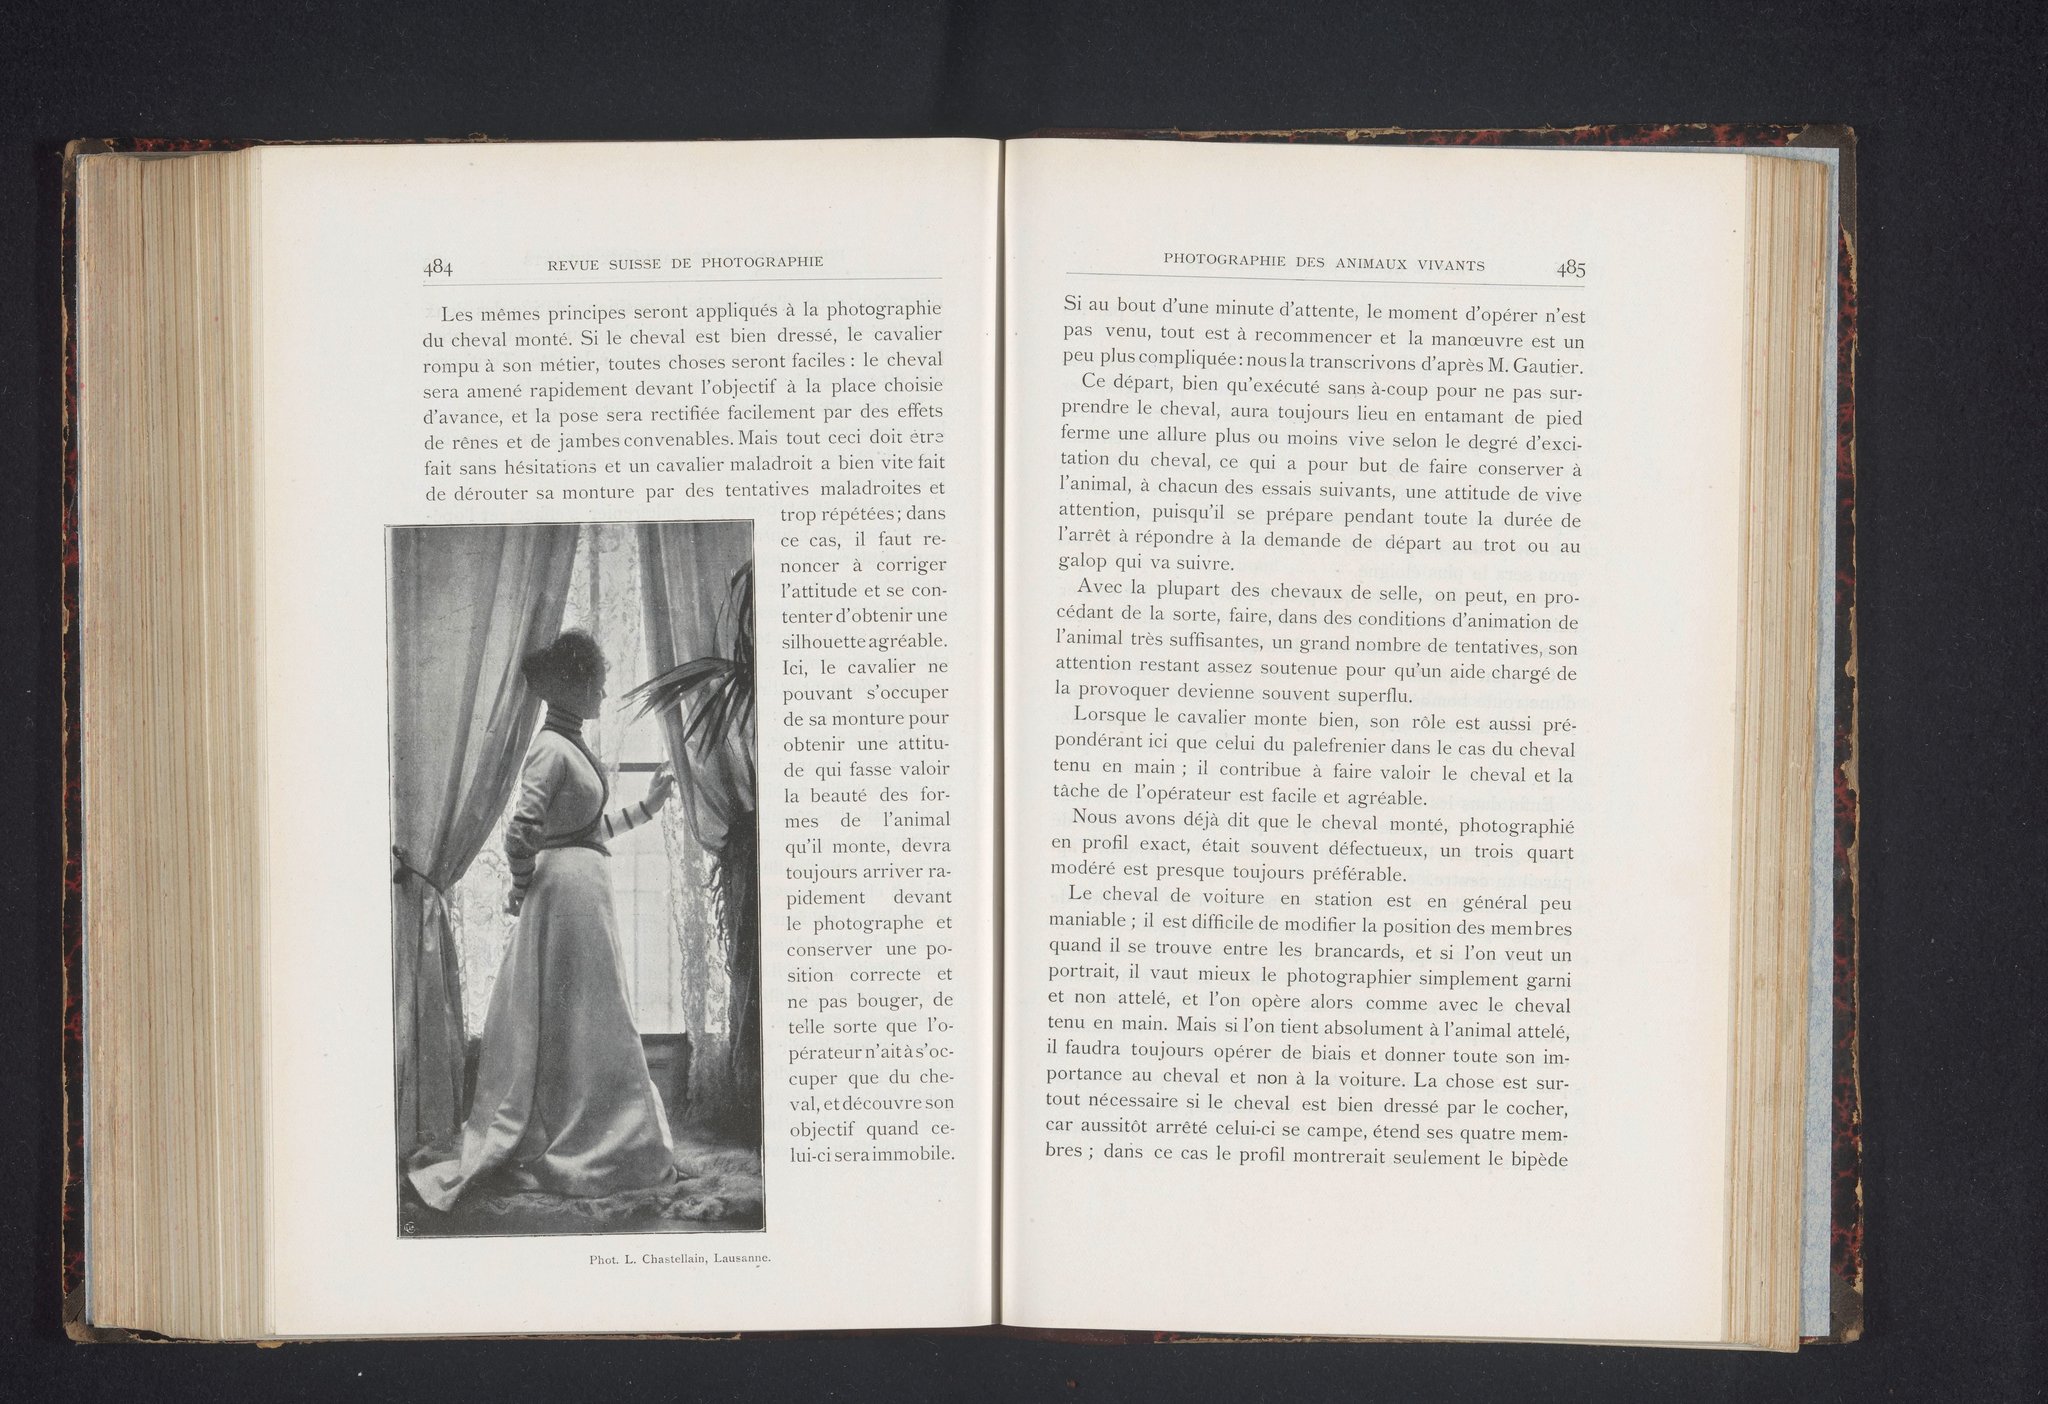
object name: photomechanical print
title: Portret van een onbekende vrouw bij het raam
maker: l. chastellain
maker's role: fotograaf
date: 1897-1902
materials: paper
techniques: autotype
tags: historical persons - bb - woman, human figure at (open) window, seen from inside - aa - feigned window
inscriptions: monogram: ‘C. Cie’